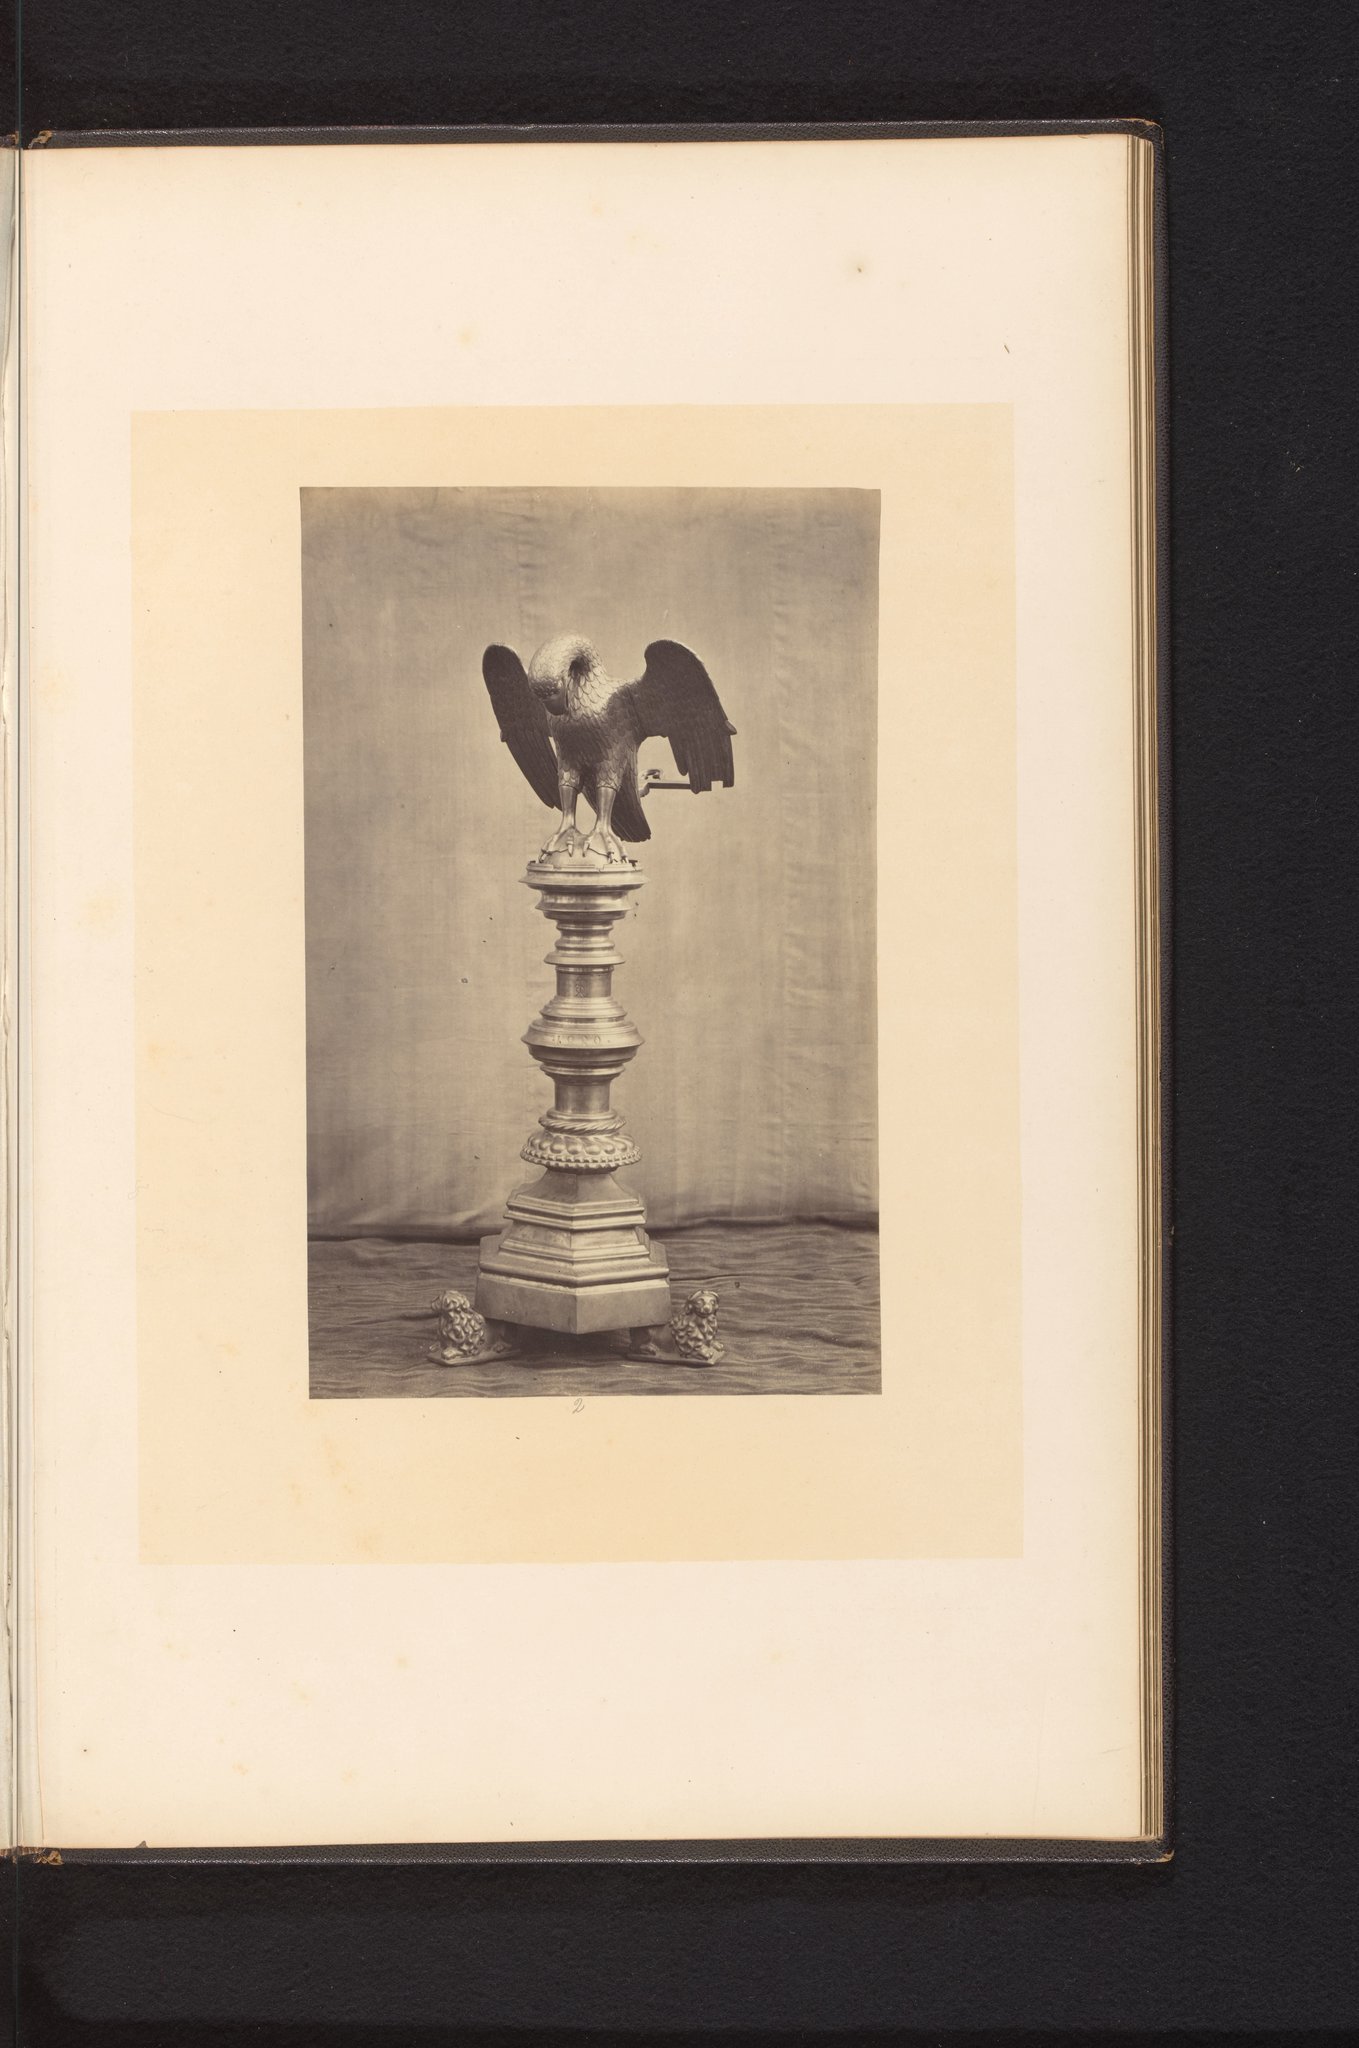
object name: photograph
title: Drie metalen kandelabers, opgesteld op een tentoonstelling over religieuze objecten uit de middeleeuwen en renaissance in 1864 in Mechelen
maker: joseph maes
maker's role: fotograaf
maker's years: 1838-1908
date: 1864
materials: photographic support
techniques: albumen print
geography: mechelen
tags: chandelier, candelabrum, mechelen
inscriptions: number: ‘5 - 4 - 3’